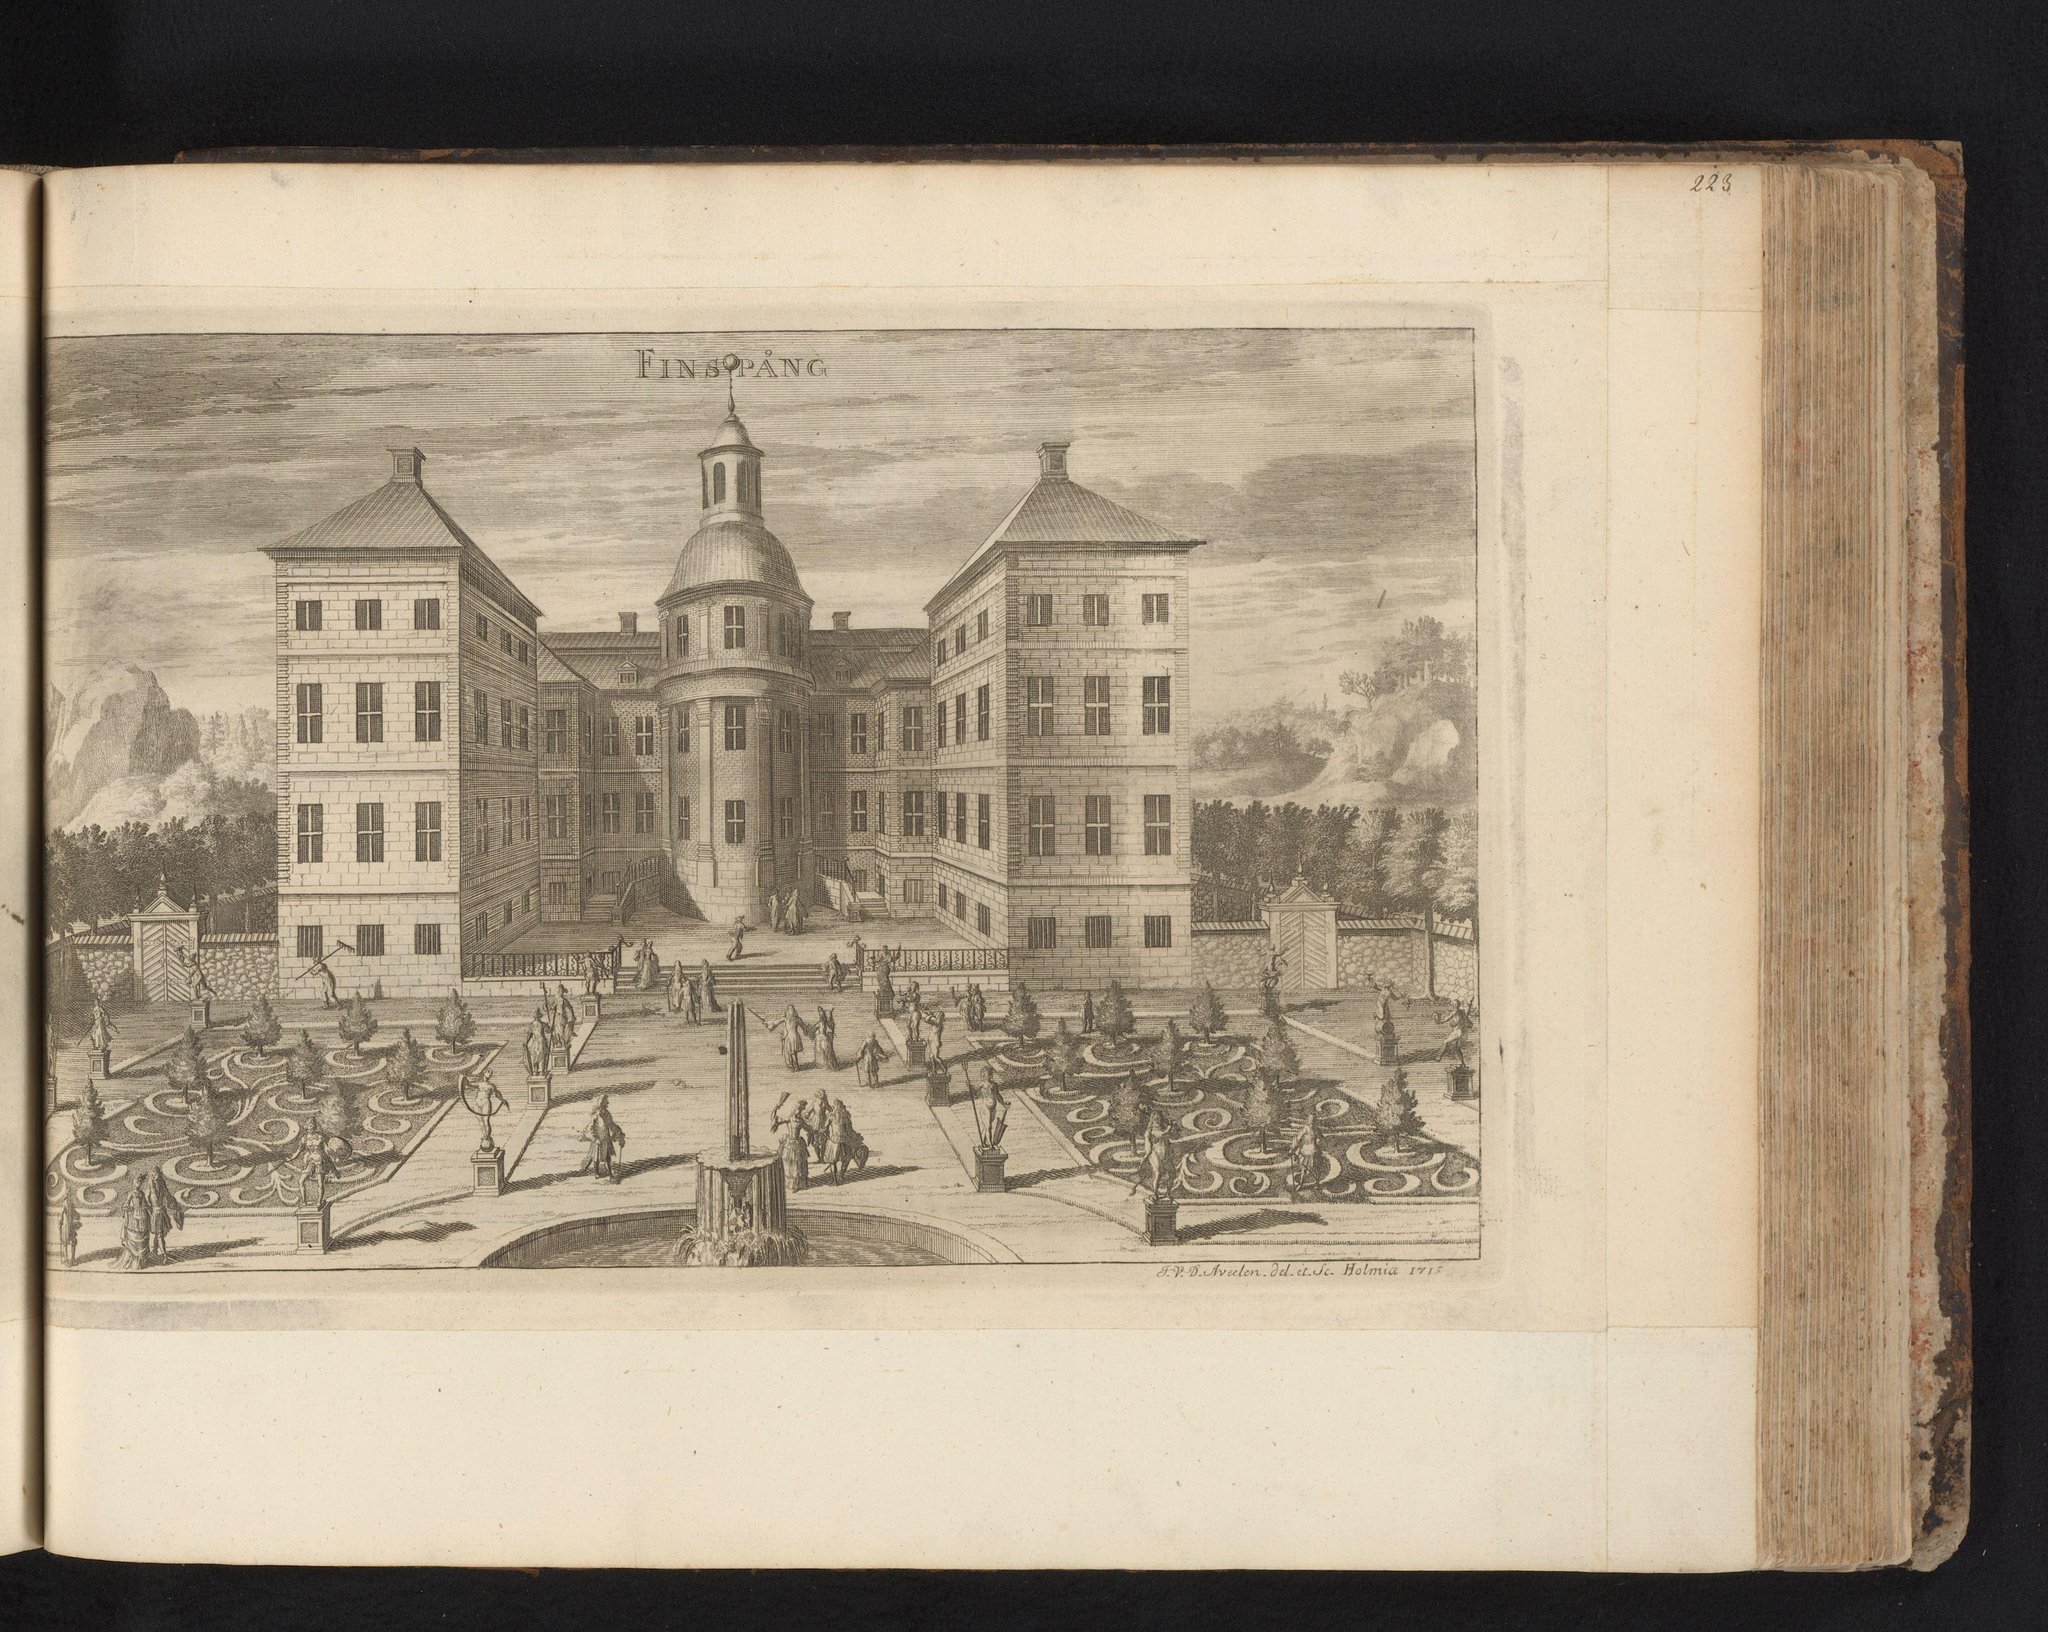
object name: album leaf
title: Finspång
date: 1715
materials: paper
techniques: etching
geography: stockholm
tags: housing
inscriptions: date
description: Kungliga Biblioteket, 'Suecia': http://www.kb.se/samlingarna/Kartor-bilder/Suecia-antiqua/ (geraadpleegd november 2016).